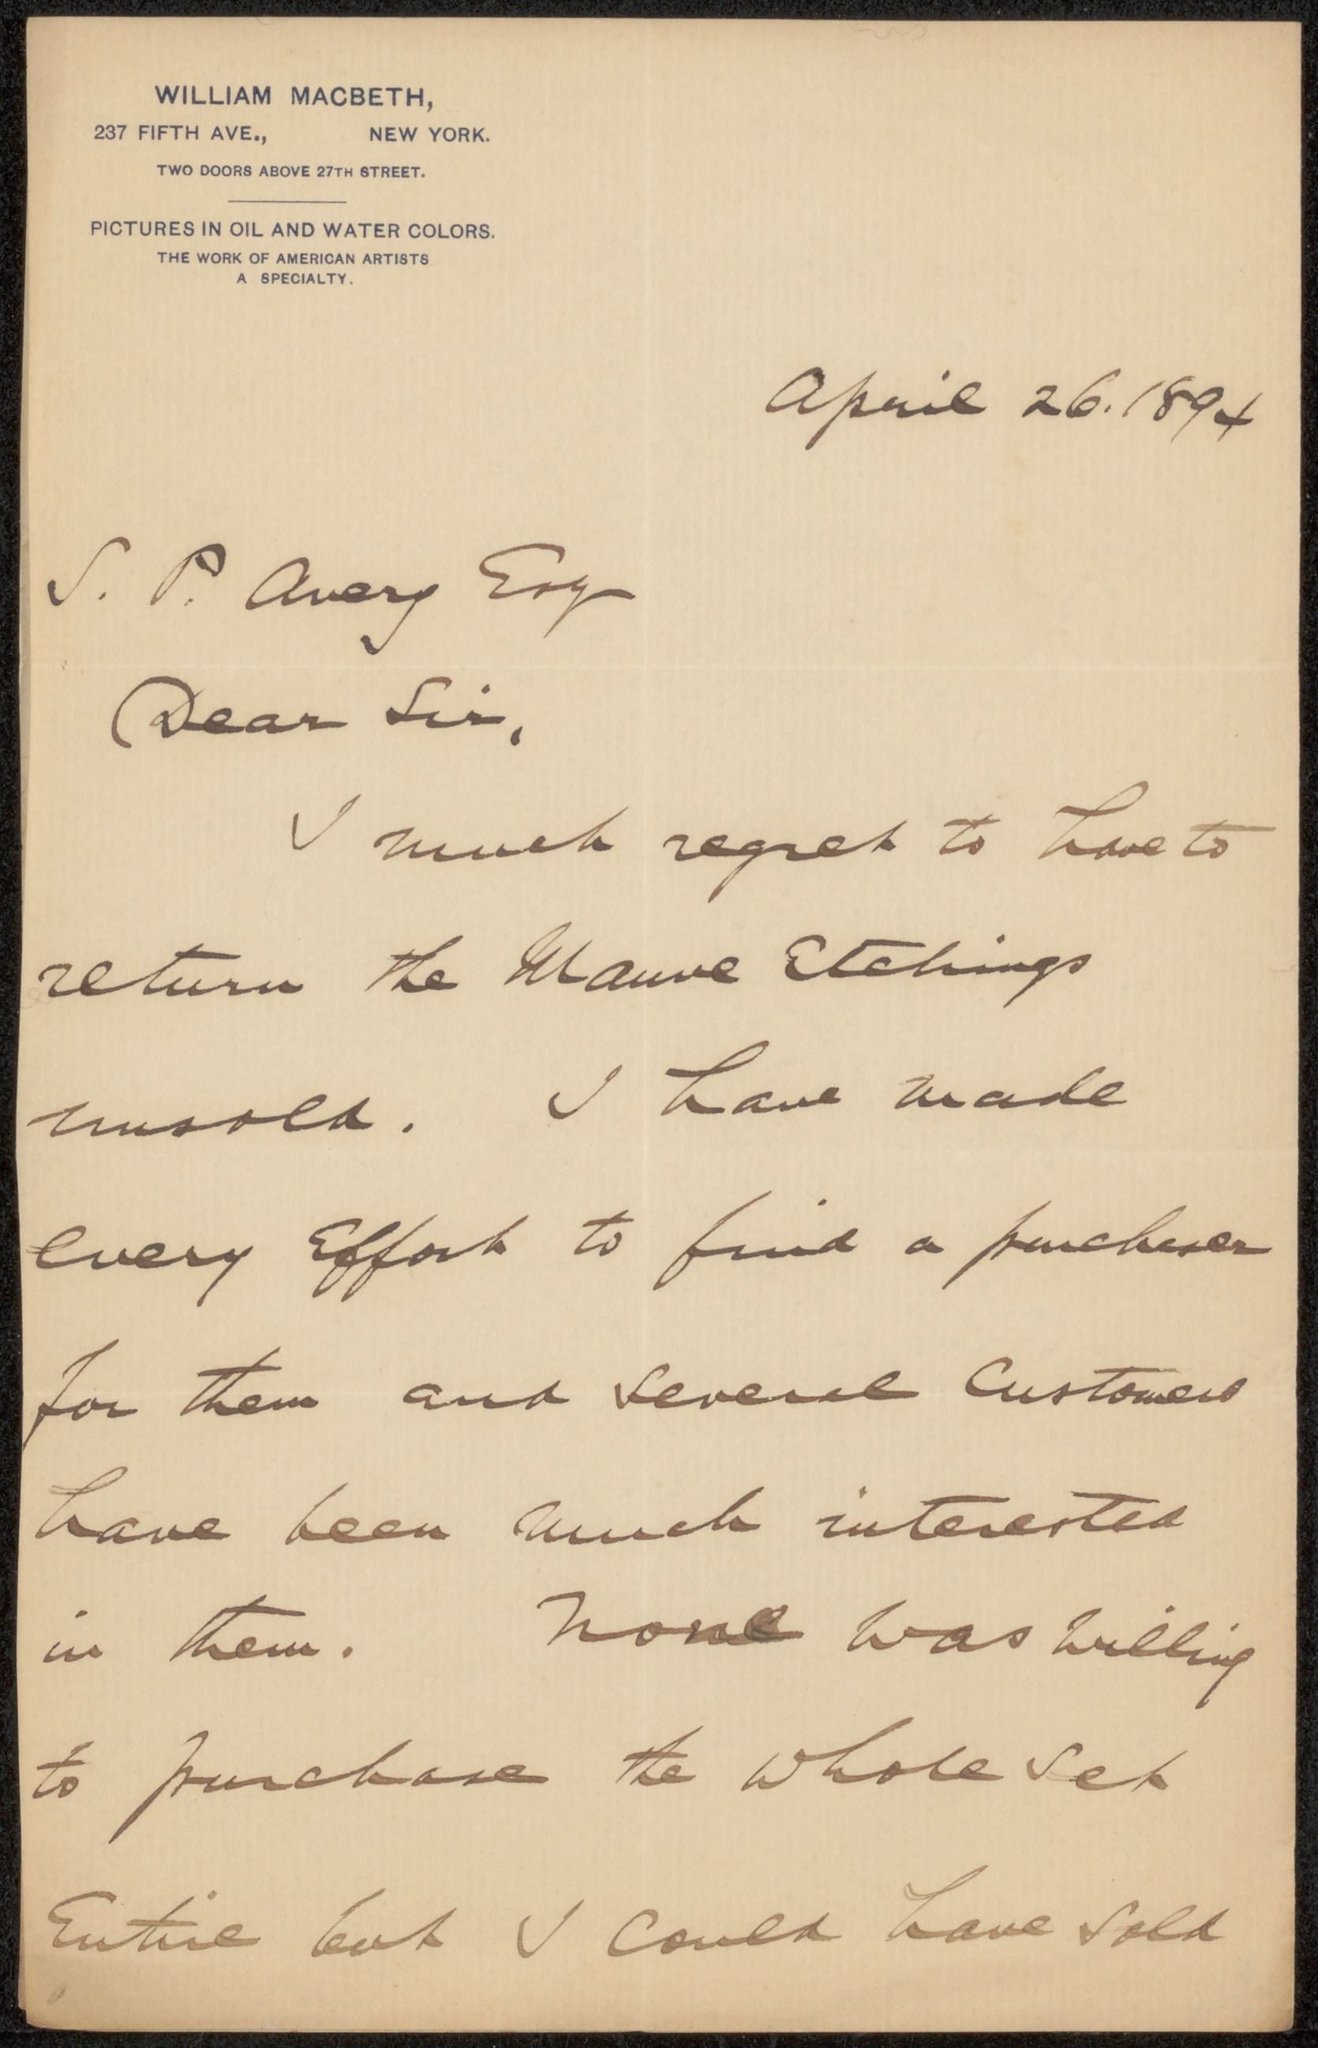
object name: letter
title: Brief aan Samuel Putnam Avery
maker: william macbeth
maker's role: galeriehouder, handelaar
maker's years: 1851-1917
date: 1894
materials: ink, paper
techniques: pen, printing, writing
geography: new york city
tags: arnhem, painter, print maker, draughtsman, anton mauve, new york (city), samuel putnam avery, philip zilcken, art trade, art shop, the graphic arts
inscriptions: collector's mark: ‘RPK’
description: Deze brief werd waarschijnlijk verzonden als bijlage bij brief RP-D-1982-43-AVERY-45.